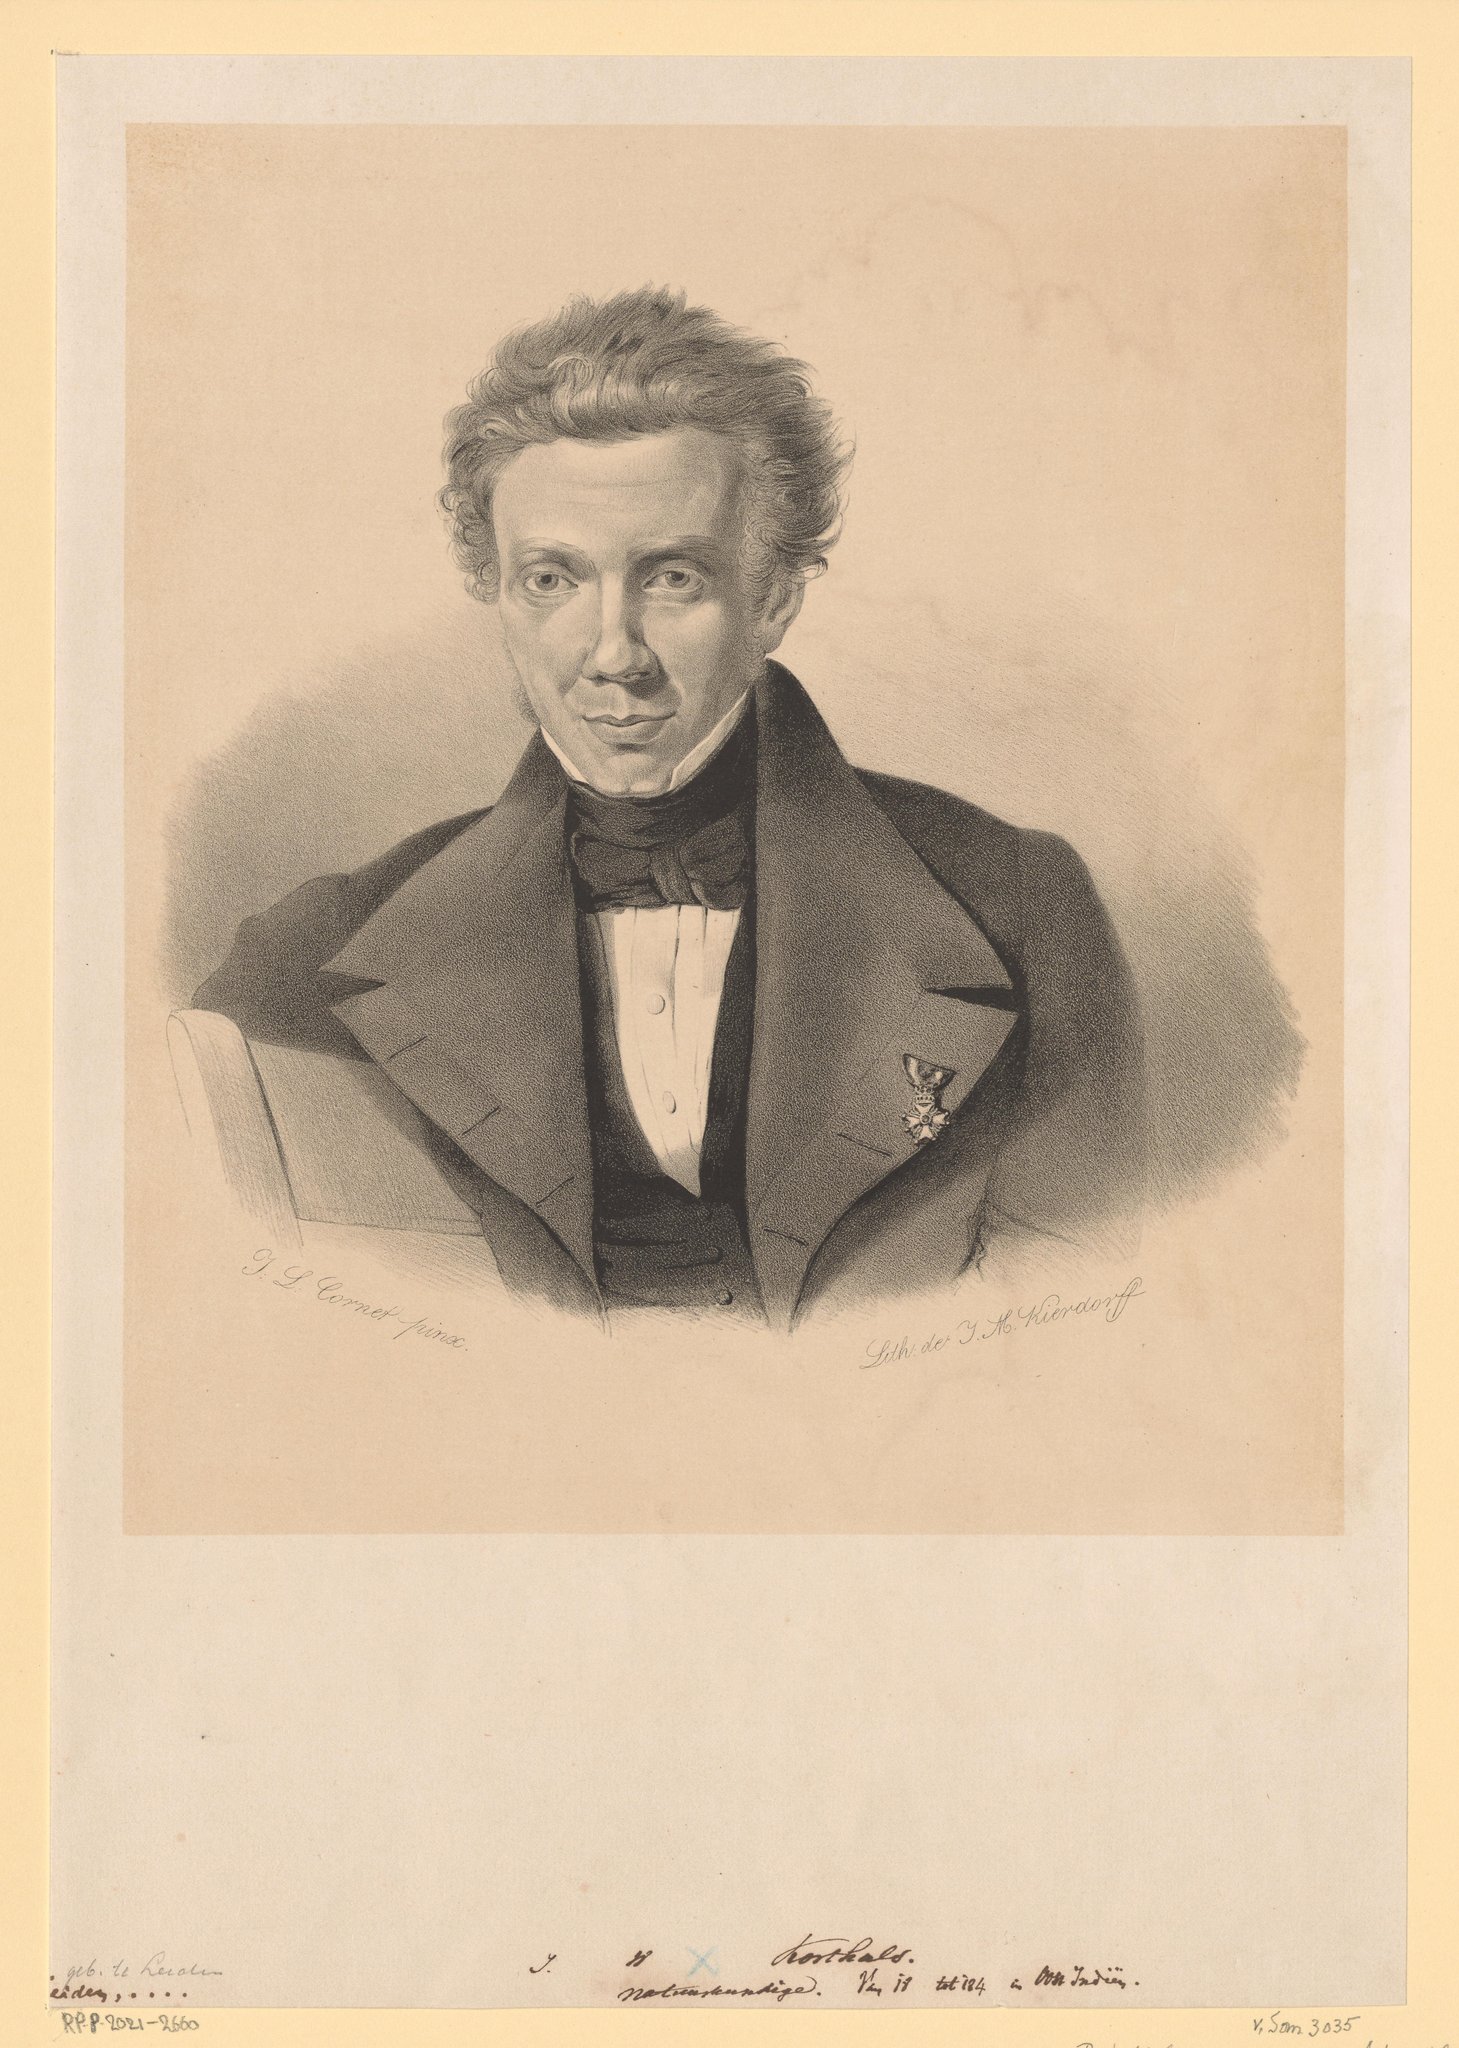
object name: print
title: Portret van Pieter Willem Korthals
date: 1813-1882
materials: paper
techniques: tone lithography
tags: historical persons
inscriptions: collector's mark: Lugt 2228